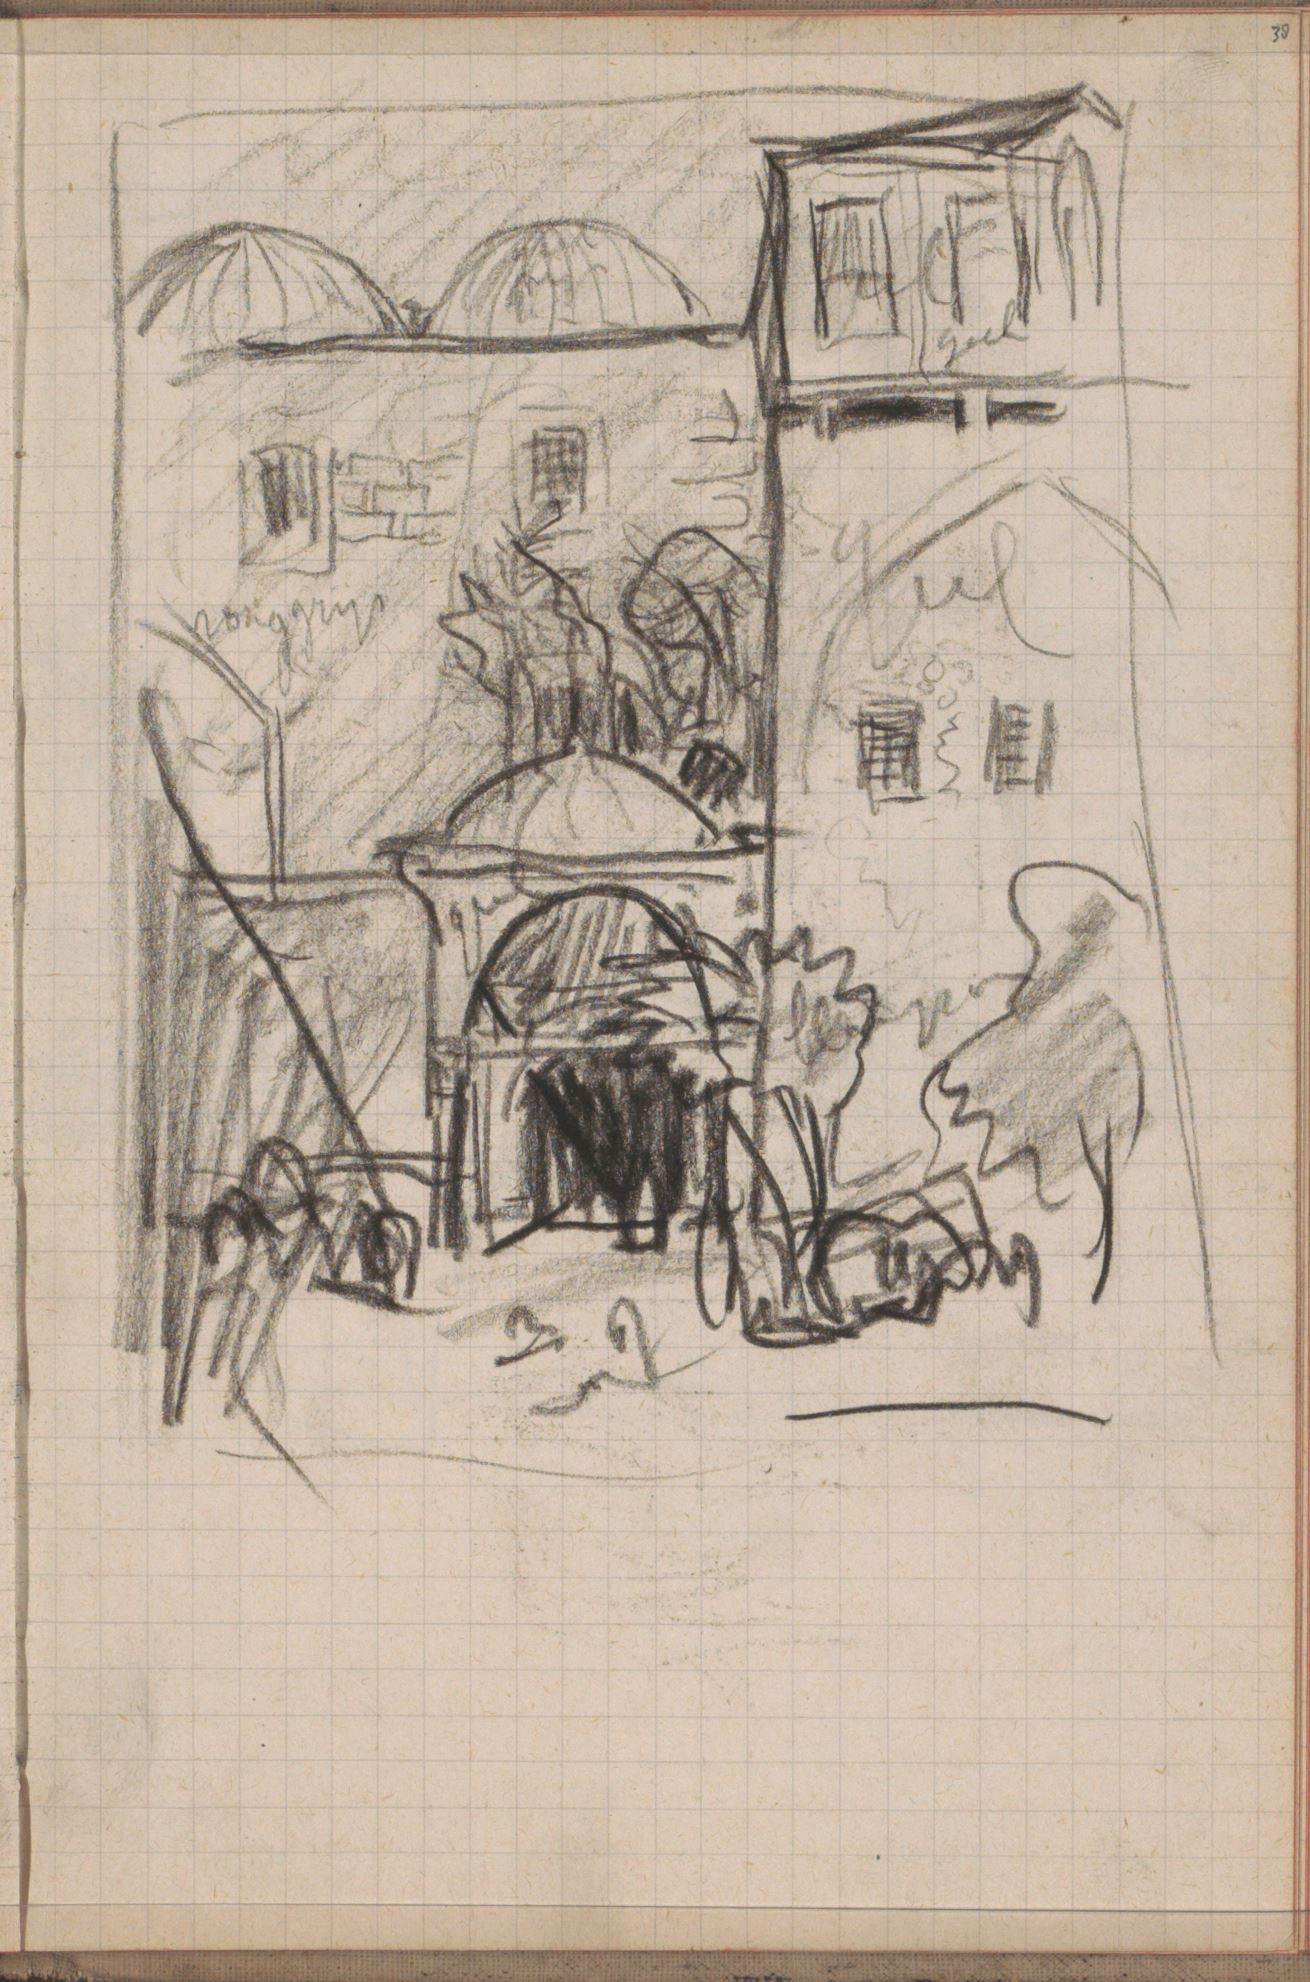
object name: sketchbook leaf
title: Gezicht op een straat met een poort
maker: marius bauer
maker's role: draughtsman, print maker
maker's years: 1867-1932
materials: chalk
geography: istanbul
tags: dome ~ architecture, street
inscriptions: kleurnotitie, handgeschreven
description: Pagina 38 uit een schetsboek met 54 bladen.